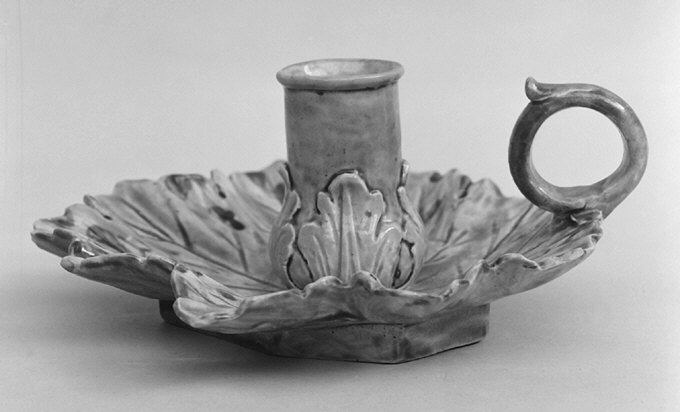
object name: candlestick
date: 1755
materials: stoneware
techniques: salt glaze